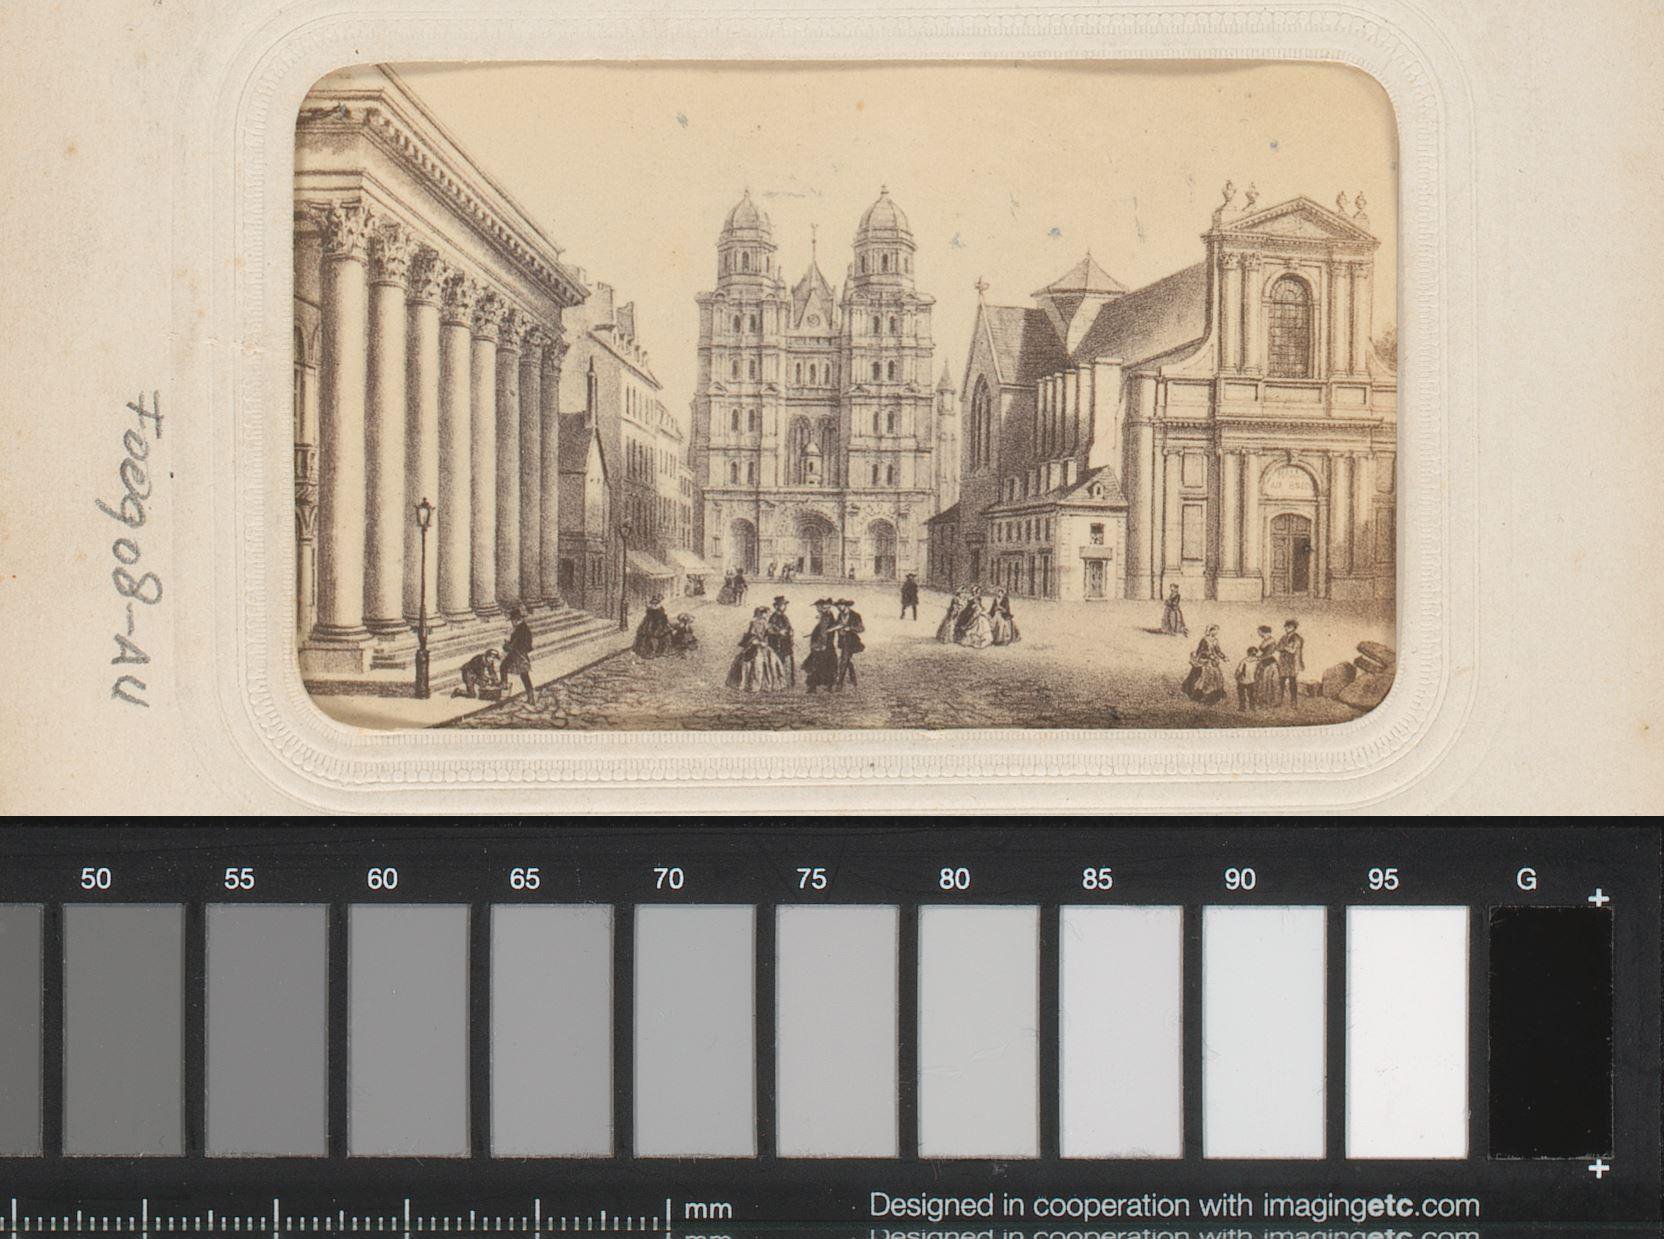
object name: photograph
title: Fotoreproductie van een prent van een gezicht op Place du Théâtre te Dijon met het Grand Théâtre, Église Saint-Michel en Église Saint-Étienne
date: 1860-1885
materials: cardboard, photographic support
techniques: albumen print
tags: square, place, circus, etc., church (exterior), theatre (building)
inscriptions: inscription: ‘E. Morier./ Editeur/ Rue St. André des Arts, 52/ Paris’, annotation: ‘Theater en kerken te Dijon’, annotation: ‘Le theatre, St. Michel/ St. Etienne, Dijon’, inscription: ‘Photographie e Charon jeune/ 3 Rue Racine, Paris’